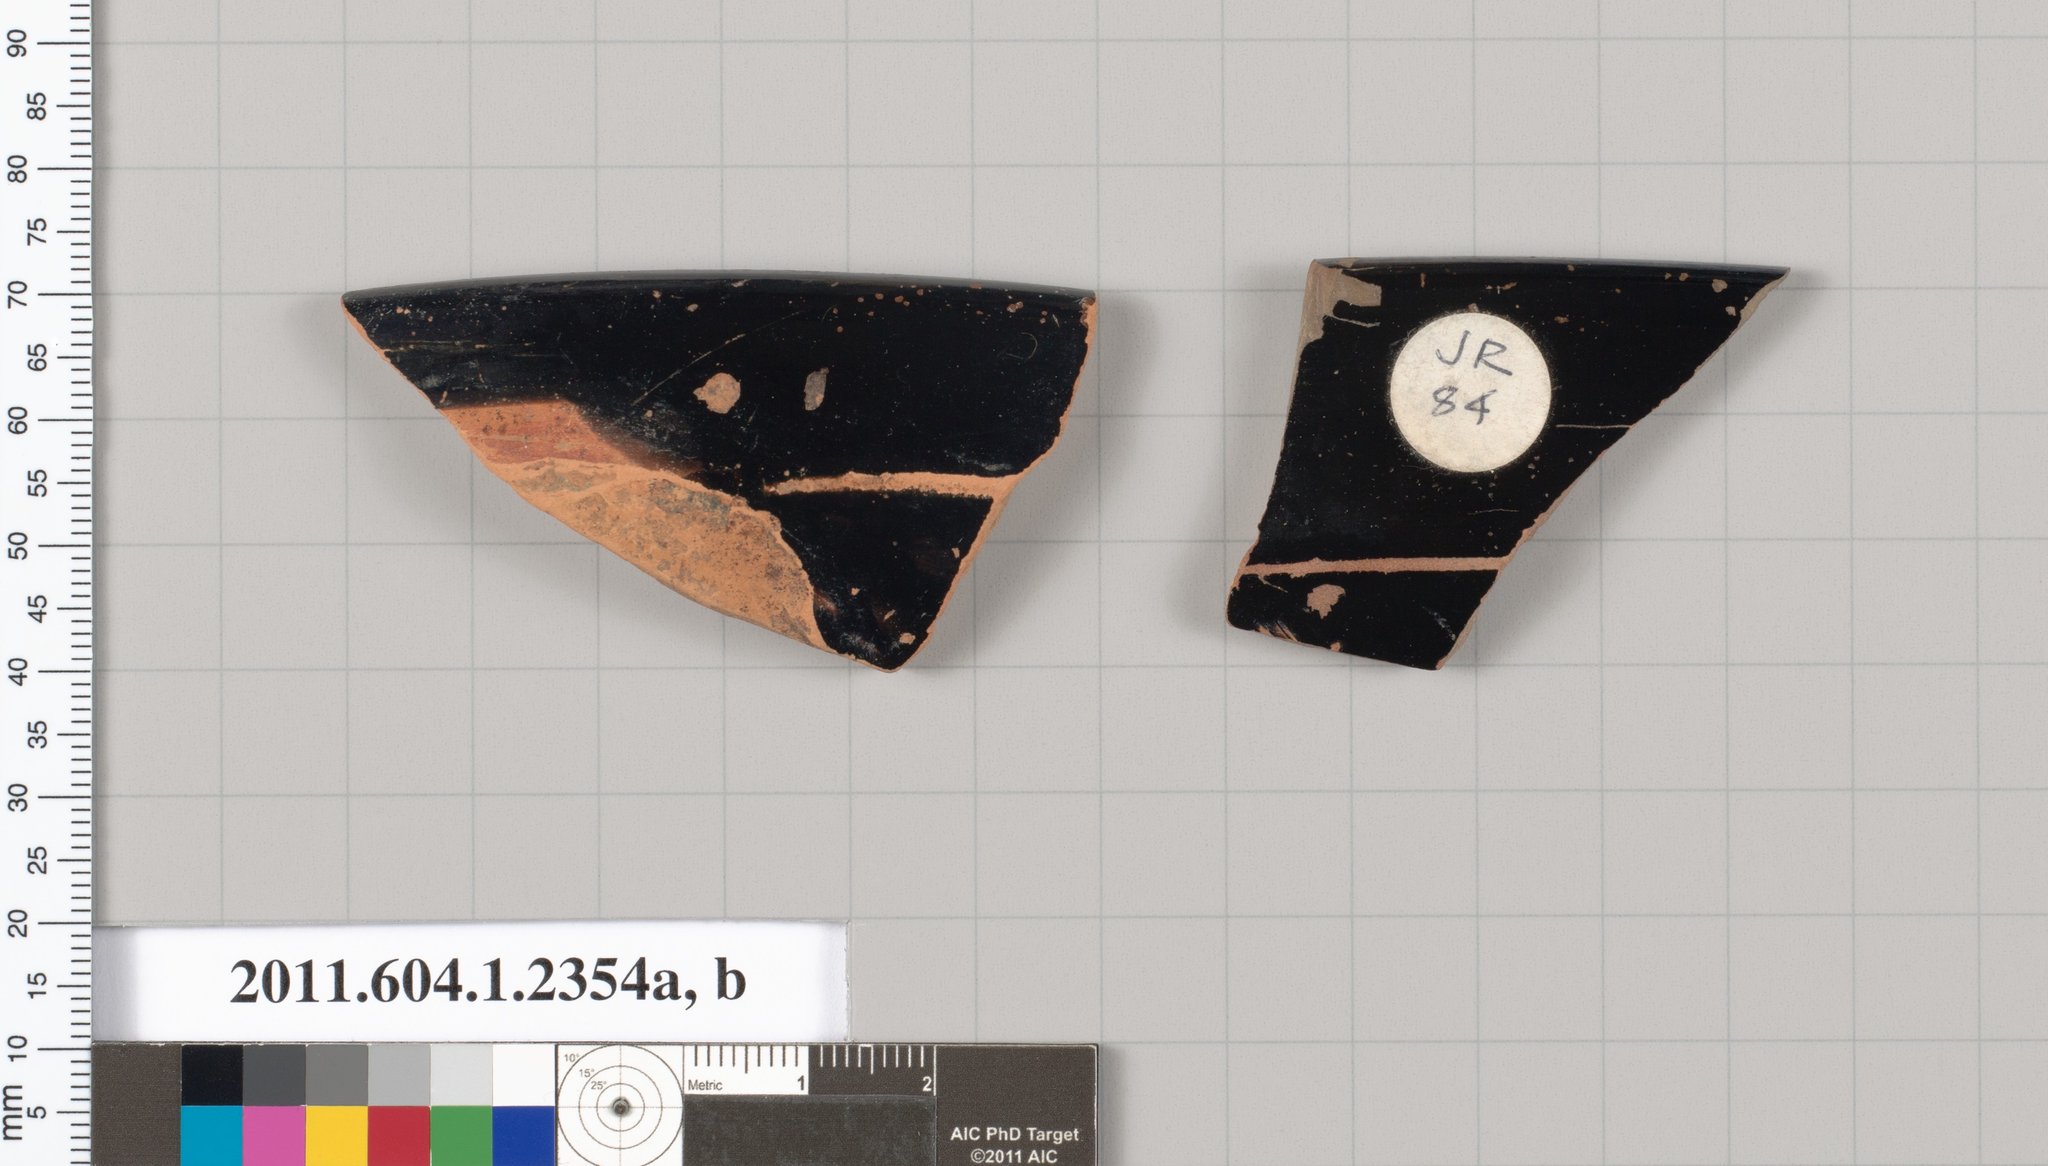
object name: kylix fragment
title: Terracotta fragments of kylikes (drinking cups)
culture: greek, attic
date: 500-451 BCE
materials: terracotta